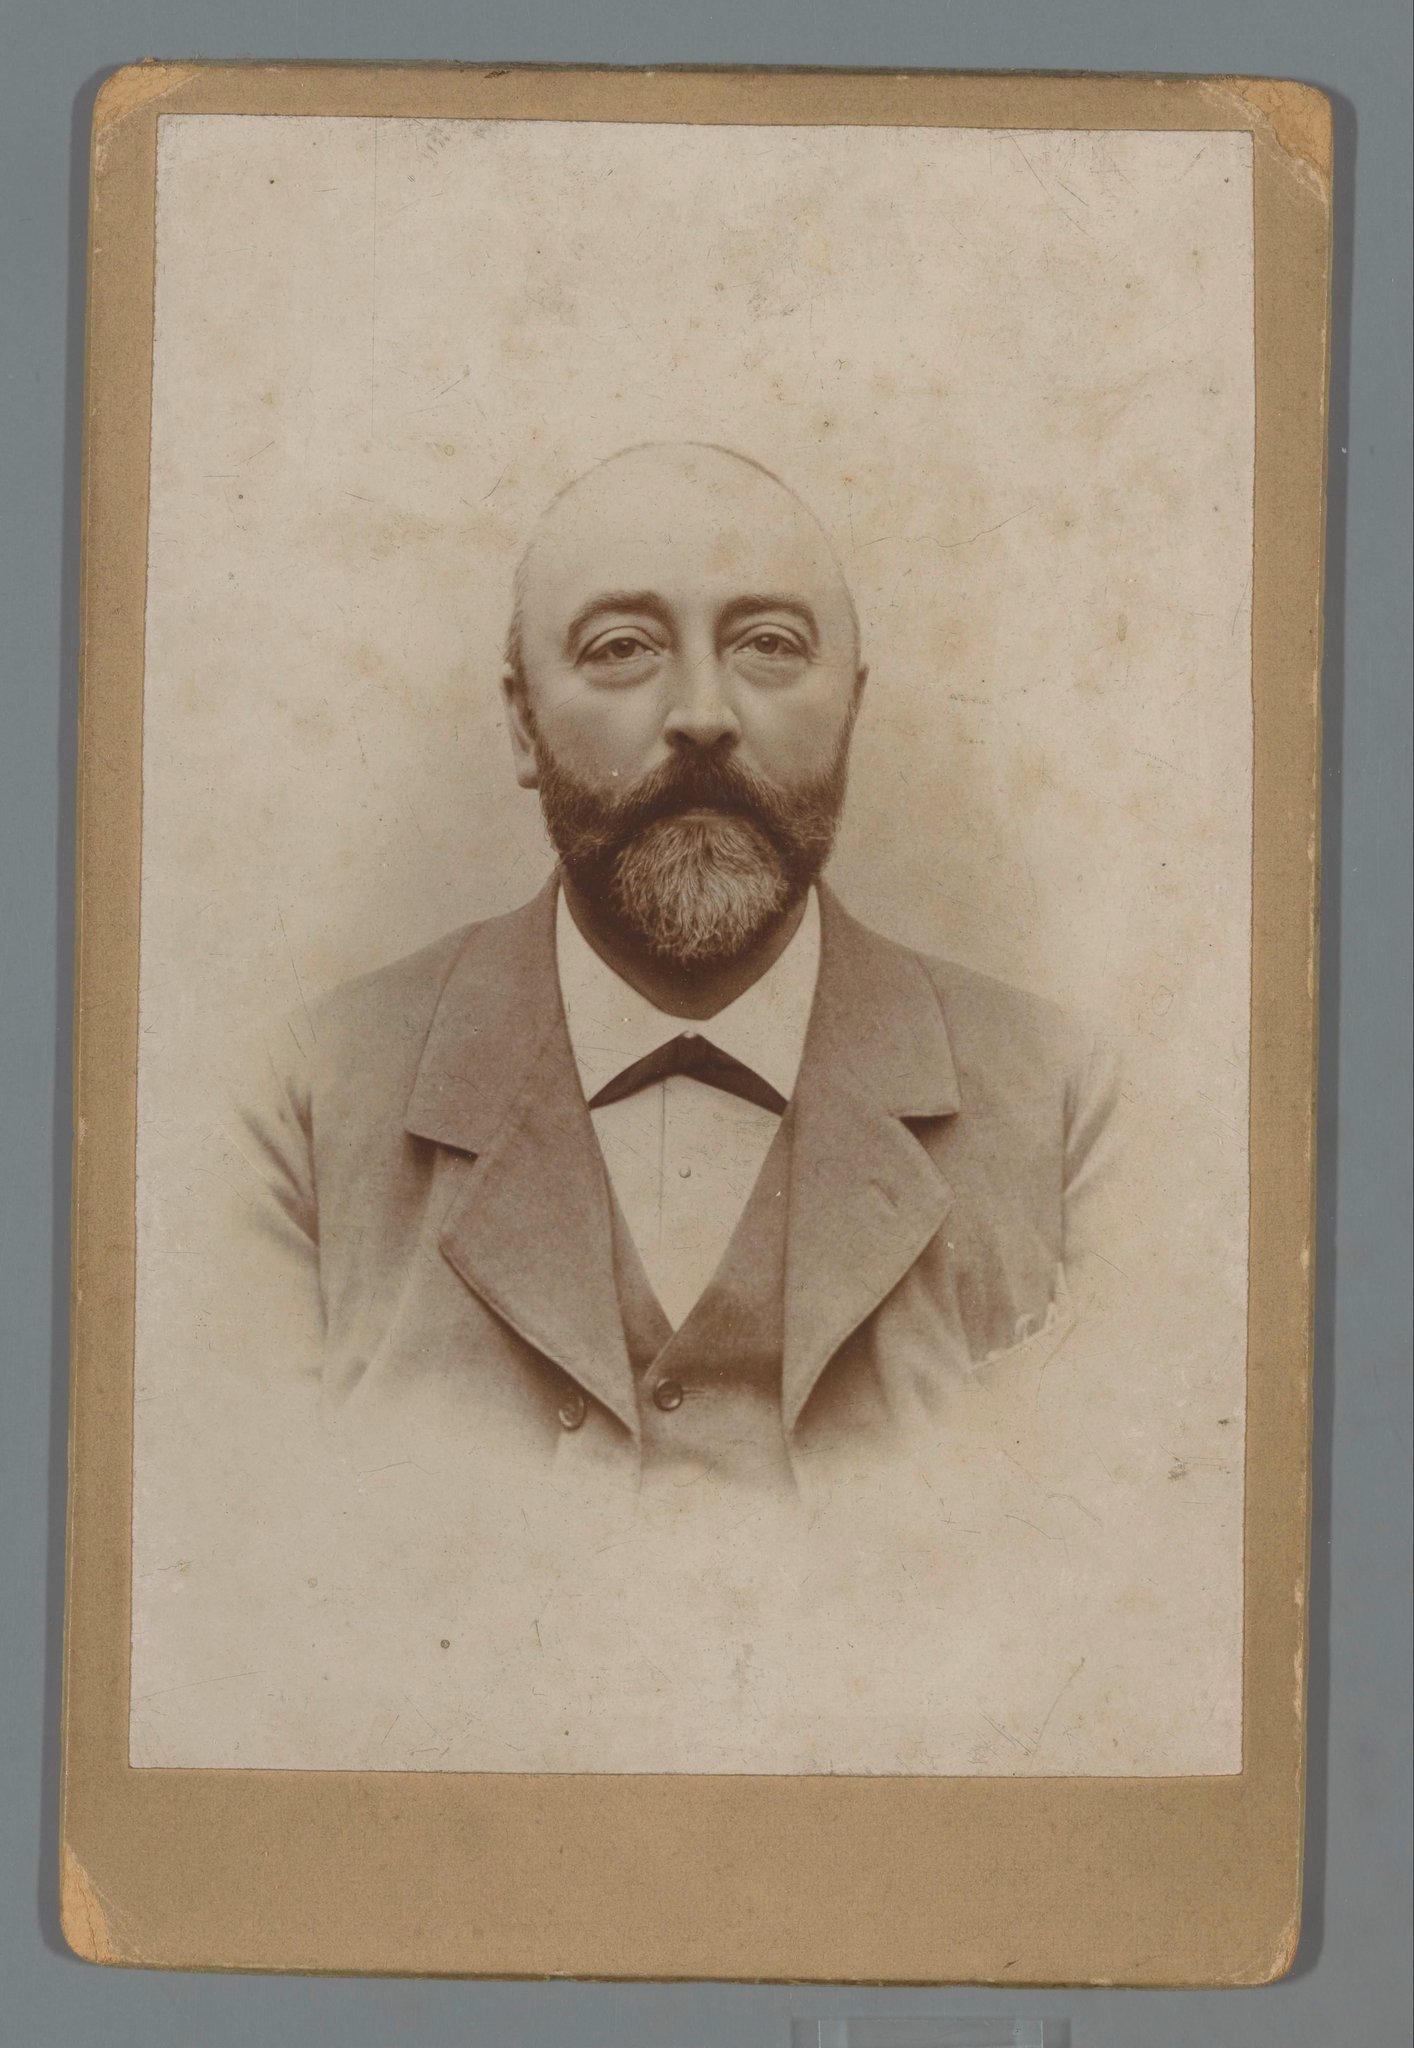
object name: cabinet photograph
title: Portret van een man met baard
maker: Anonymous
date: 1890-1910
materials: cardboard, photographic support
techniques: gelatin silver print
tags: beard